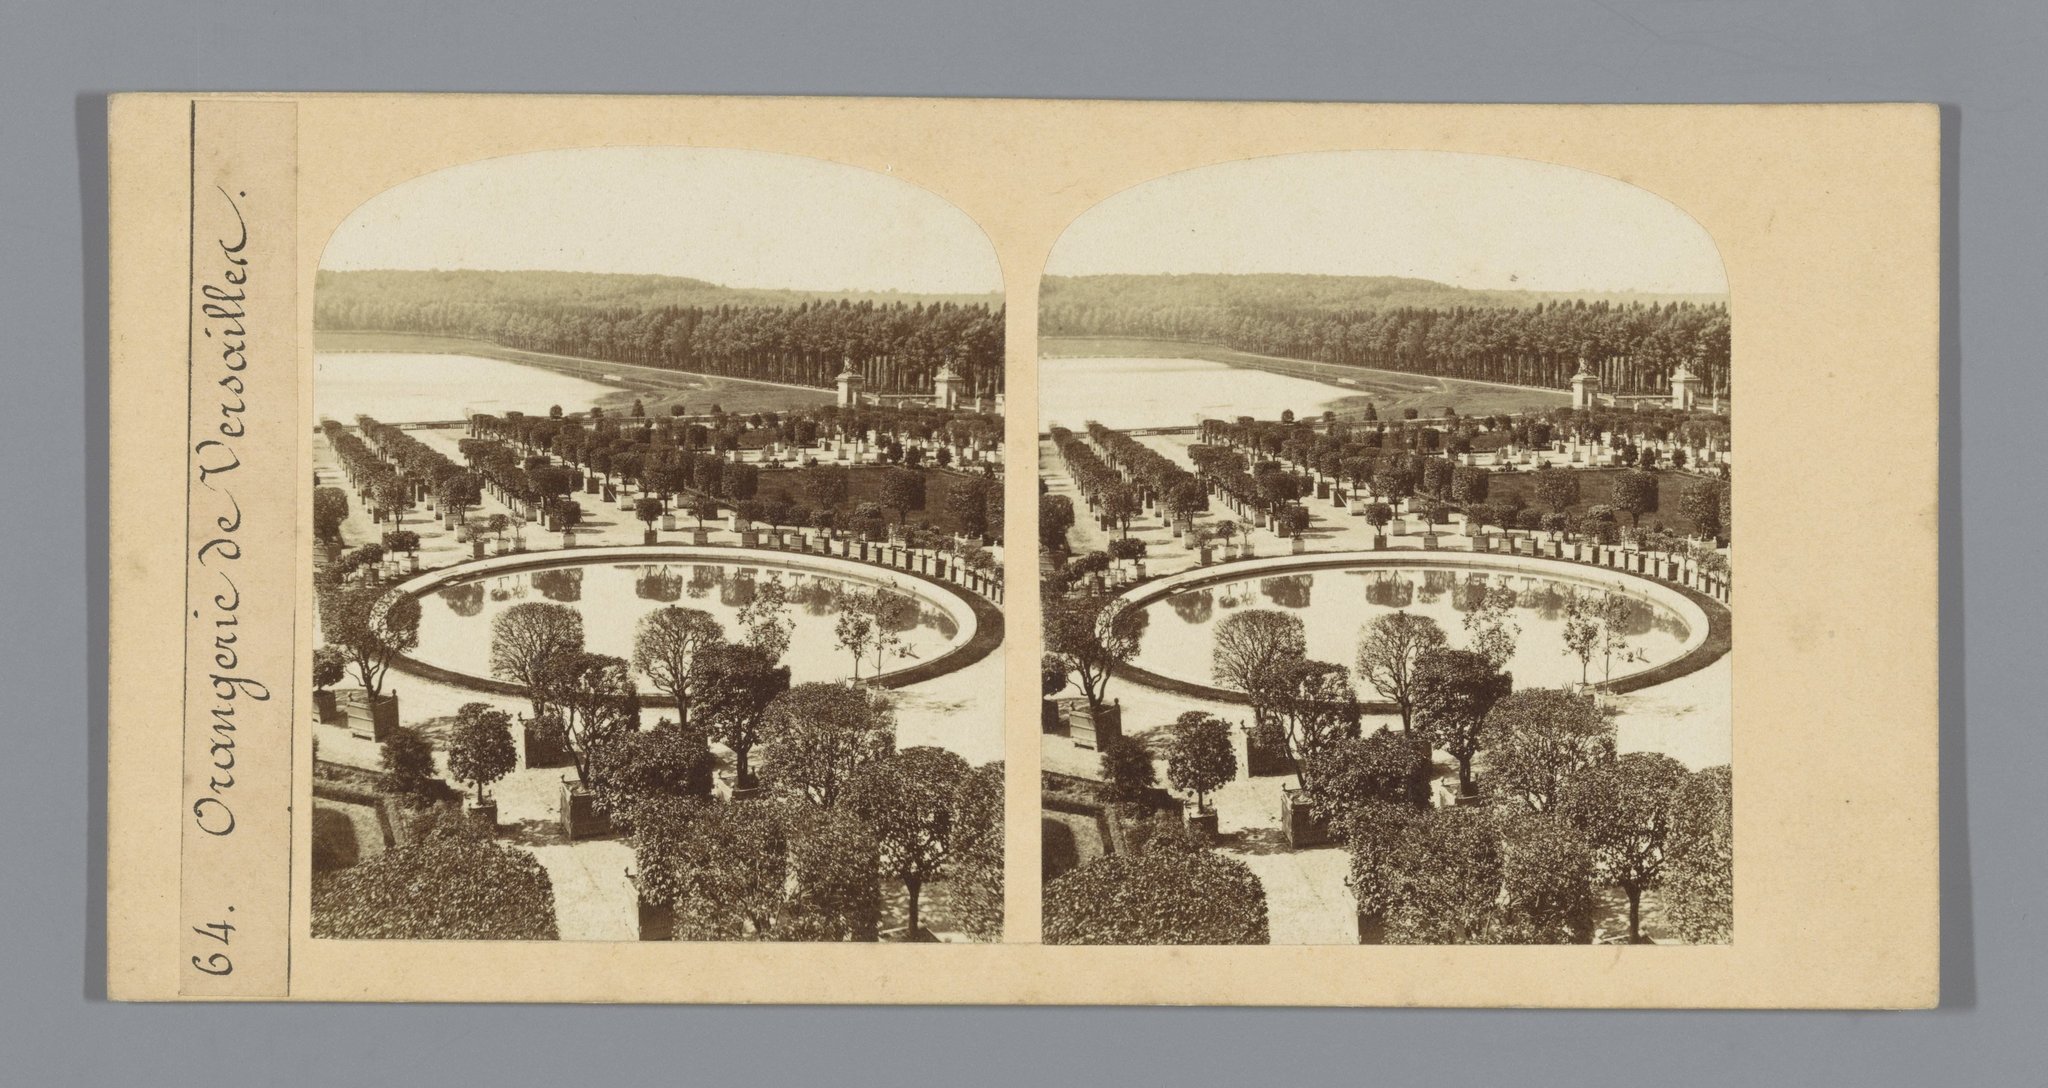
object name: stereograph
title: Gezicht op de Oranjerie van het Paleis van Versailles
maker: Anonymous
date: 1850-1875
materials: cardboard, photographic support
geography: gardens of versailles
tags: french or architectonic garden; formal garden, greenhouse, orangery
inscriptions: number: ‘64.’, inscription: ‘Orangerie de Versailles’